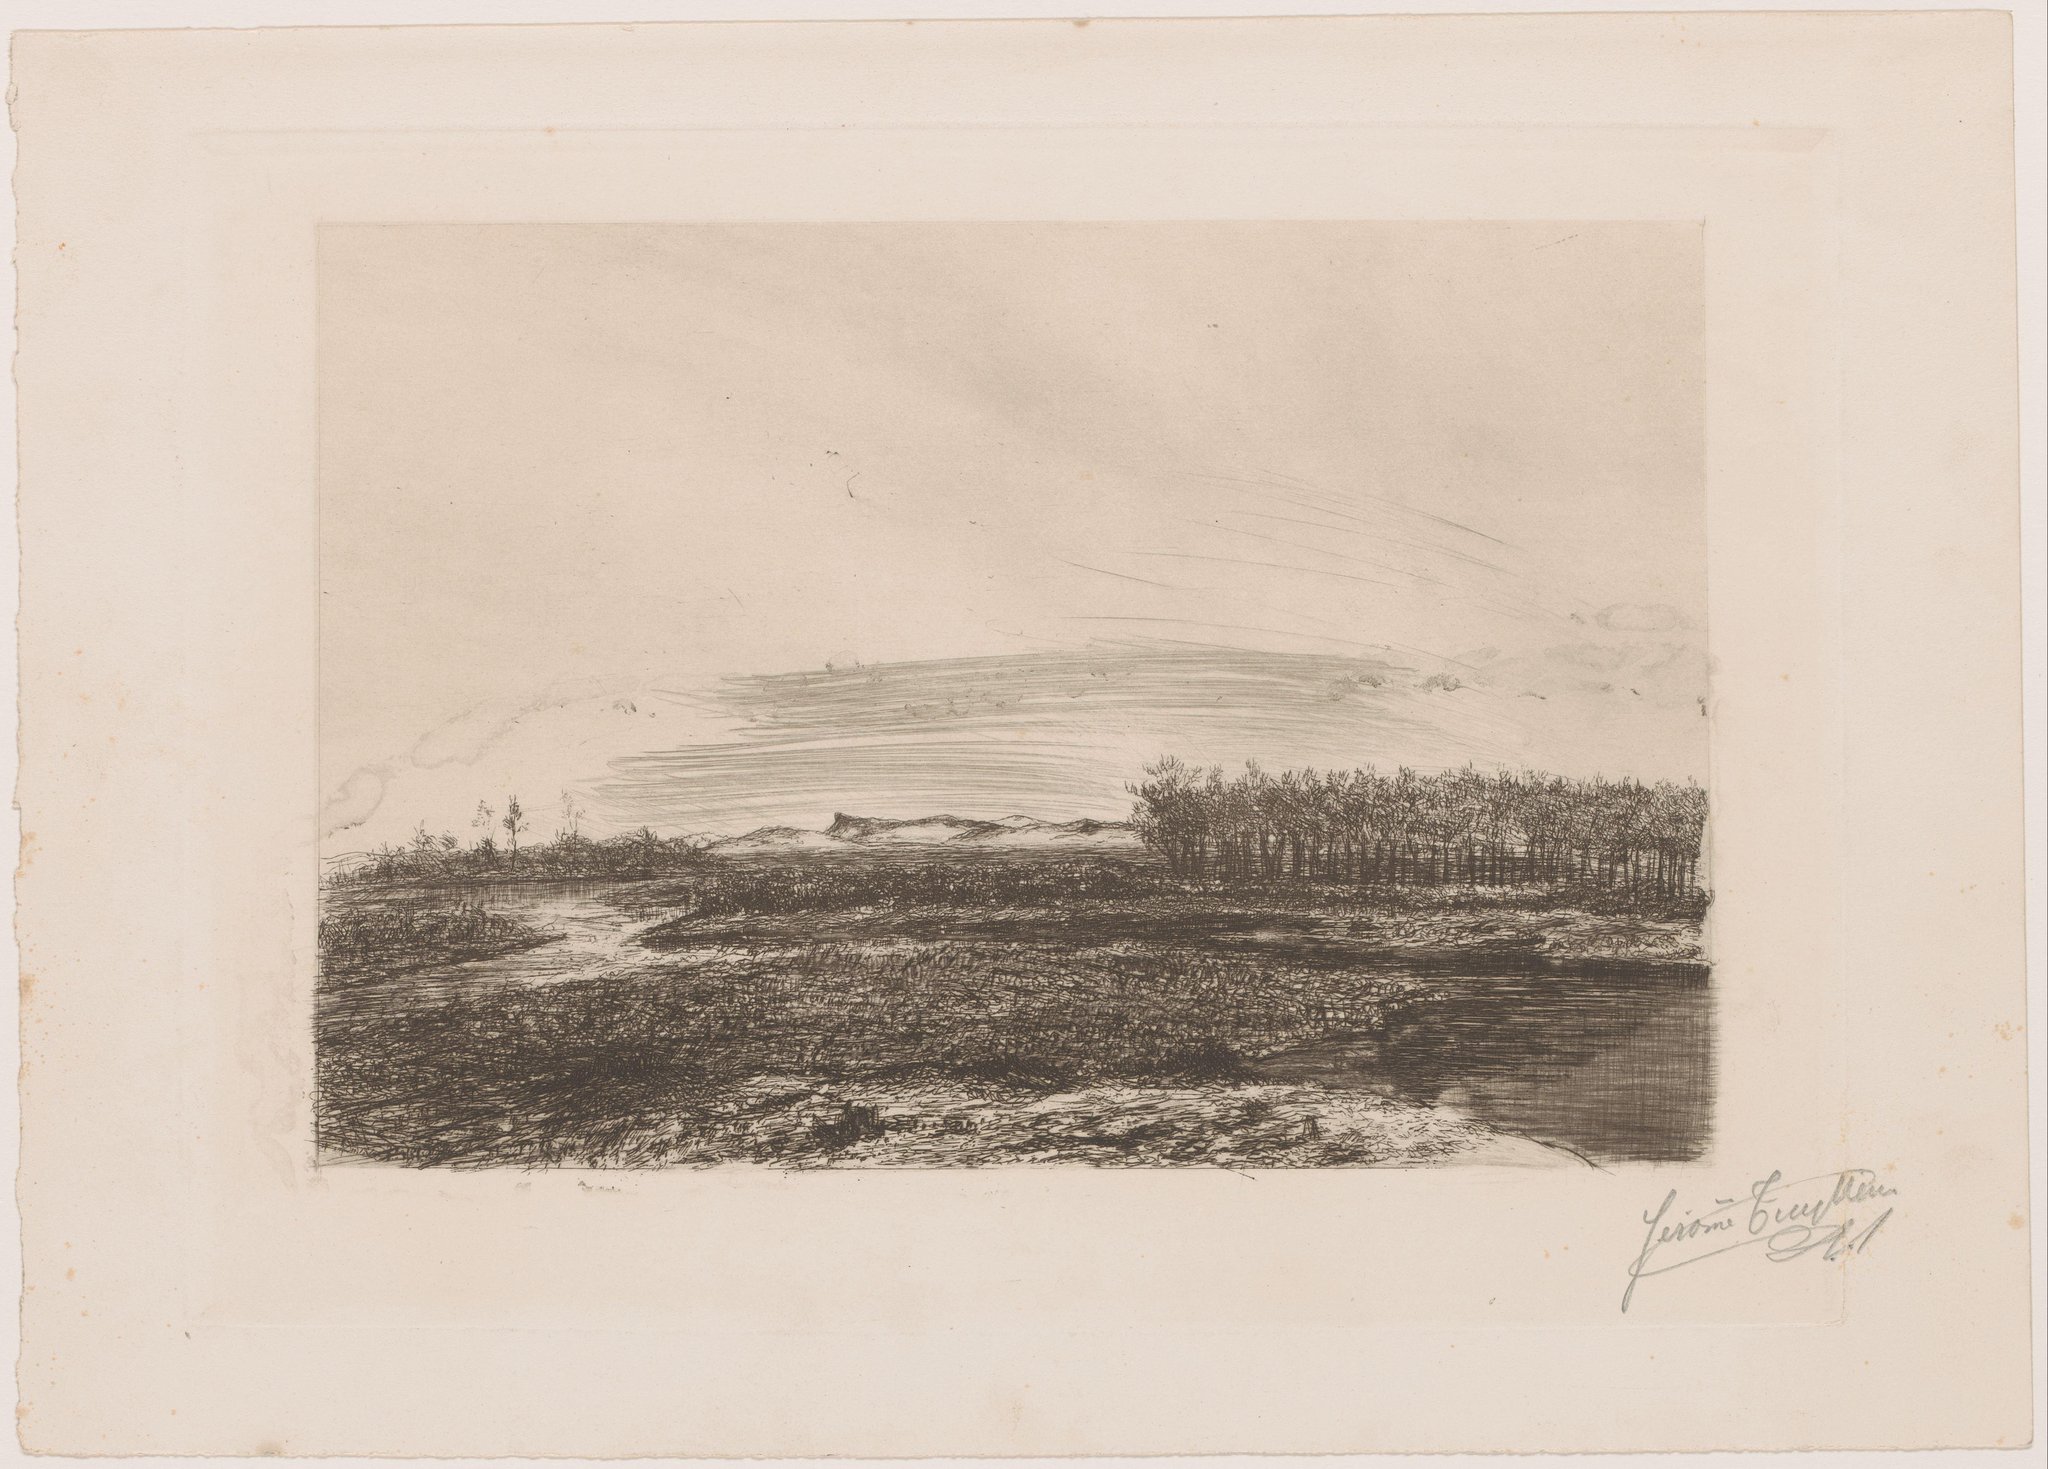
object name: print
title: Landschap in de Kempen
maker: jerôme tuyttens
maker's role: painter, print maker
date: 1850-1883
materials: paper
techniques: drypoint, etching, intaglio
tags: landscapes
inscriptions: collector's mark: Lugt 2228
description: Sterfdatum van de prentmaker is onbekend. Daarom is voor de bepaling van de rechten van dit object gebruik gemaakt van de verwervingsdatum Rijksmuseum Amsterdam.